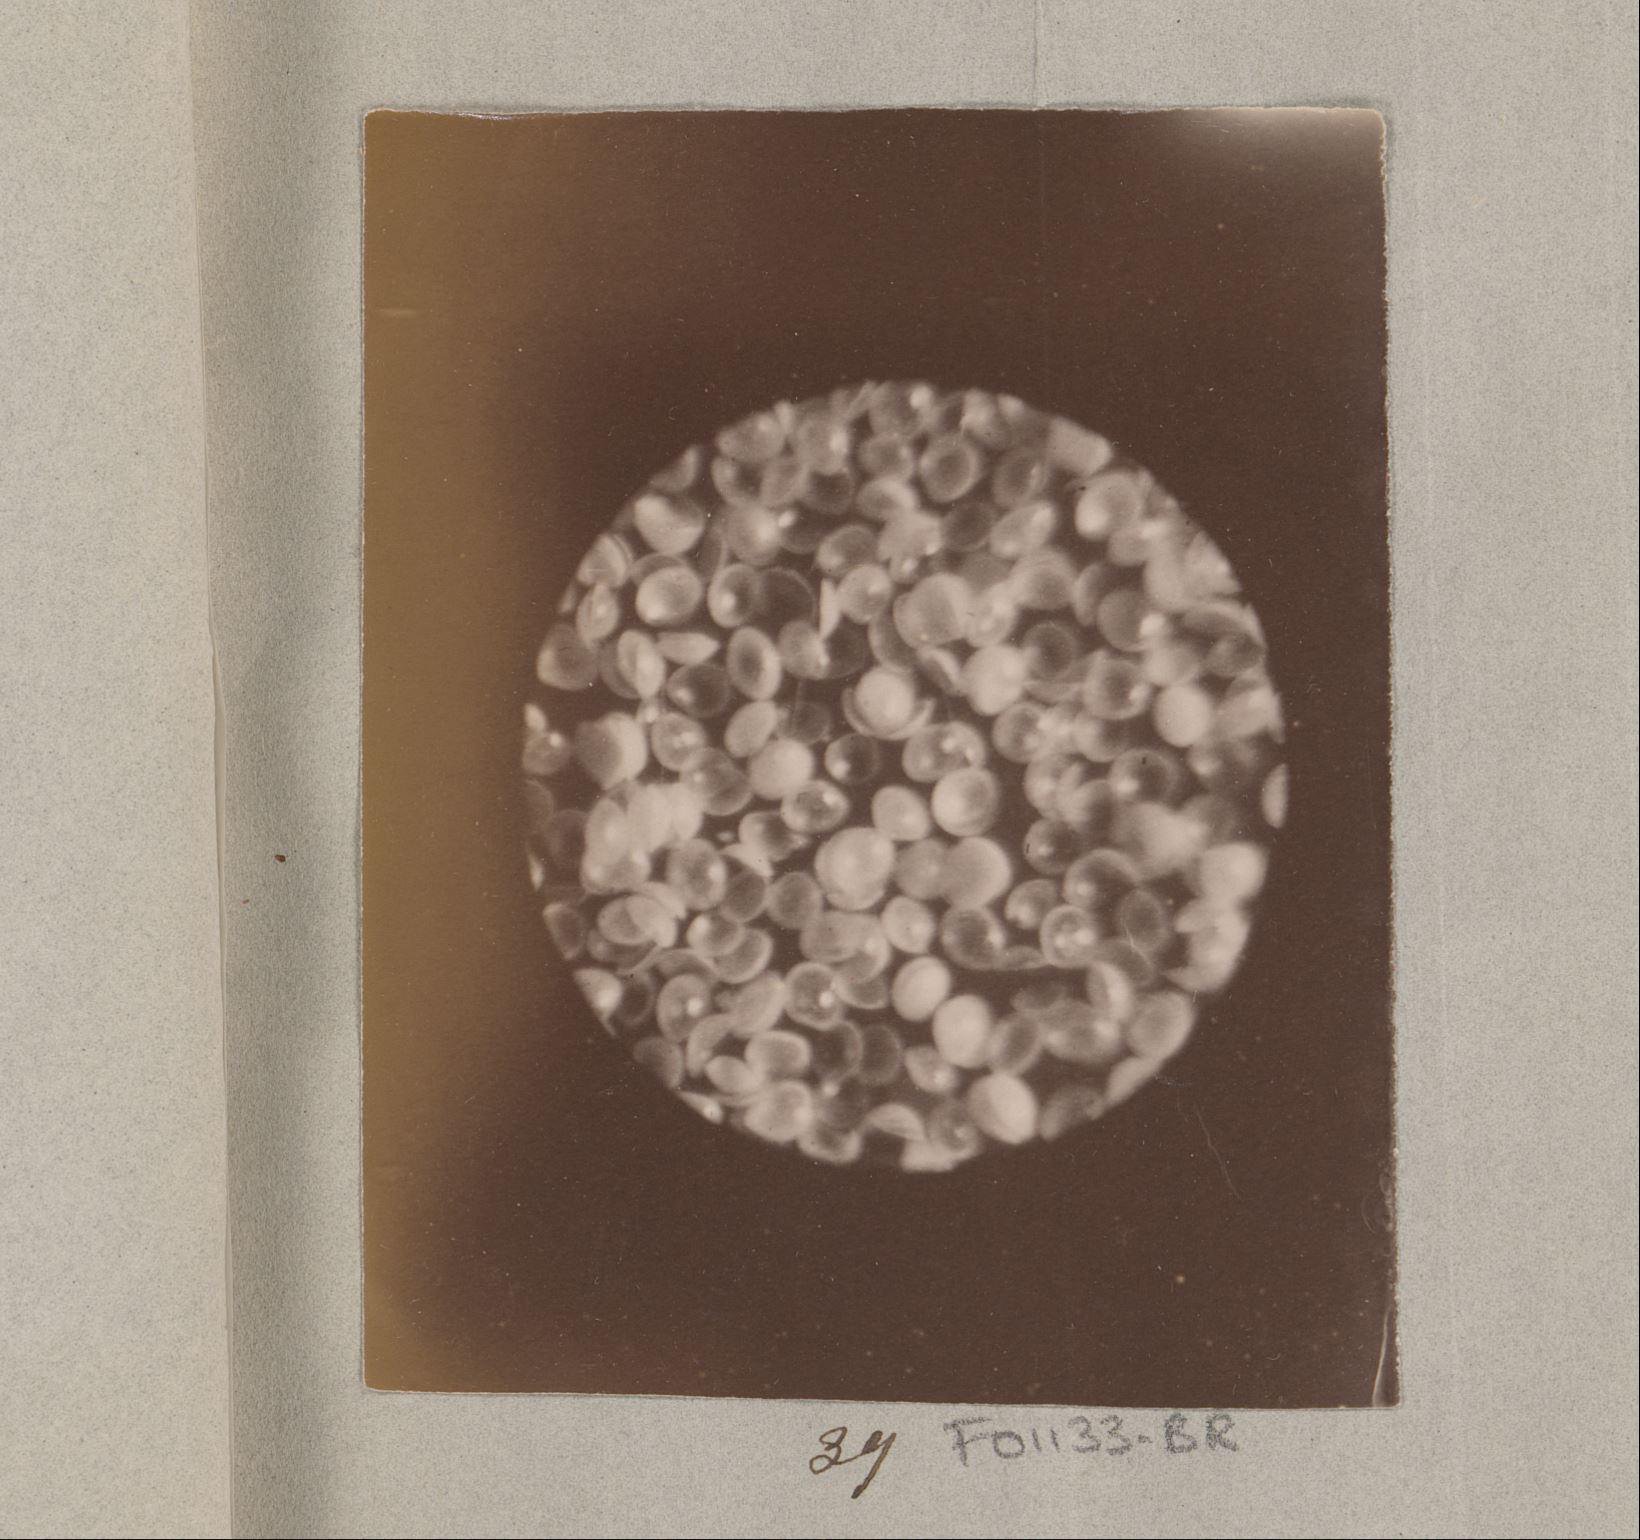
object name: album leaf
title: Microscopische opname van jonge schelpdiertjes, vijftig keer vergroot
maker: marinus pieter filbri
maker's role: instrument maker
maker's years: 1852-1917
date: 1887-1888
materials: paper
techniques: albumen print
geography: netherlands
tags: animals, netherlands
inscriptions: number: ‘39’, inscription: ‘No. 39. Benaming Jonge schelpdiertjes op vallend licht, 50 x vergroot, pose 30 min., bemerking 30 min. ontwikkeld Lomberg.’